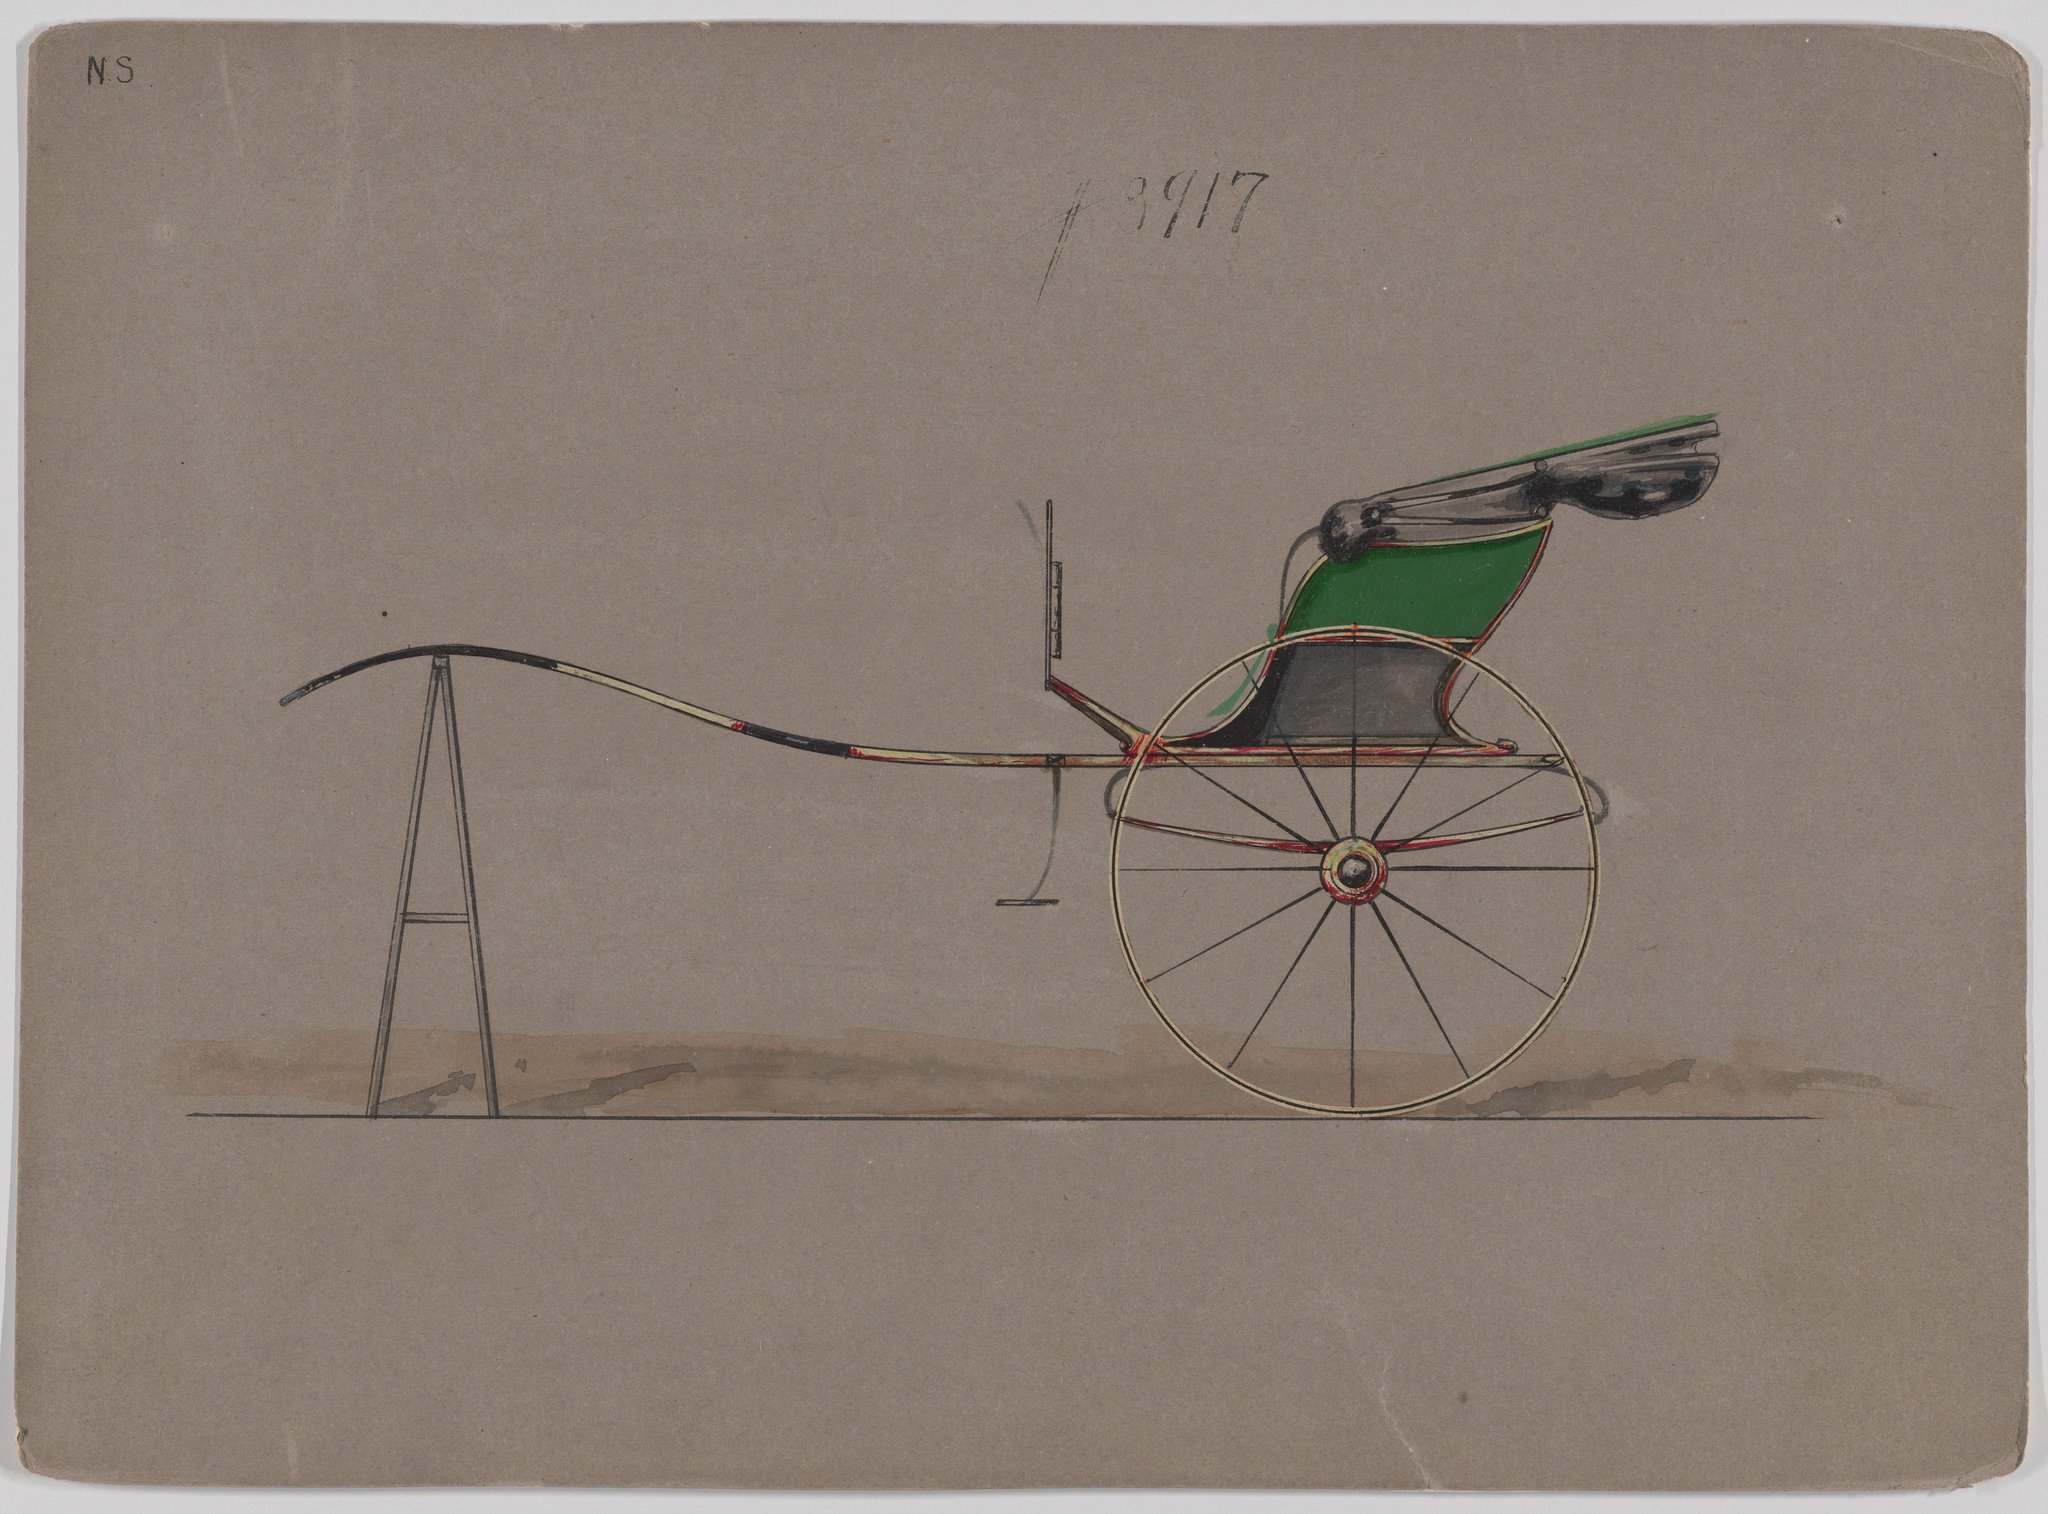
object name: drawing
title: Design for Gig, no. 3917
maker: brewster & co.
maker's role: manufacturer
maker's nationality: american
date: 1884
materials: gouache, gum arabic, ink, watercolor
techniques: pen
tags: carriages